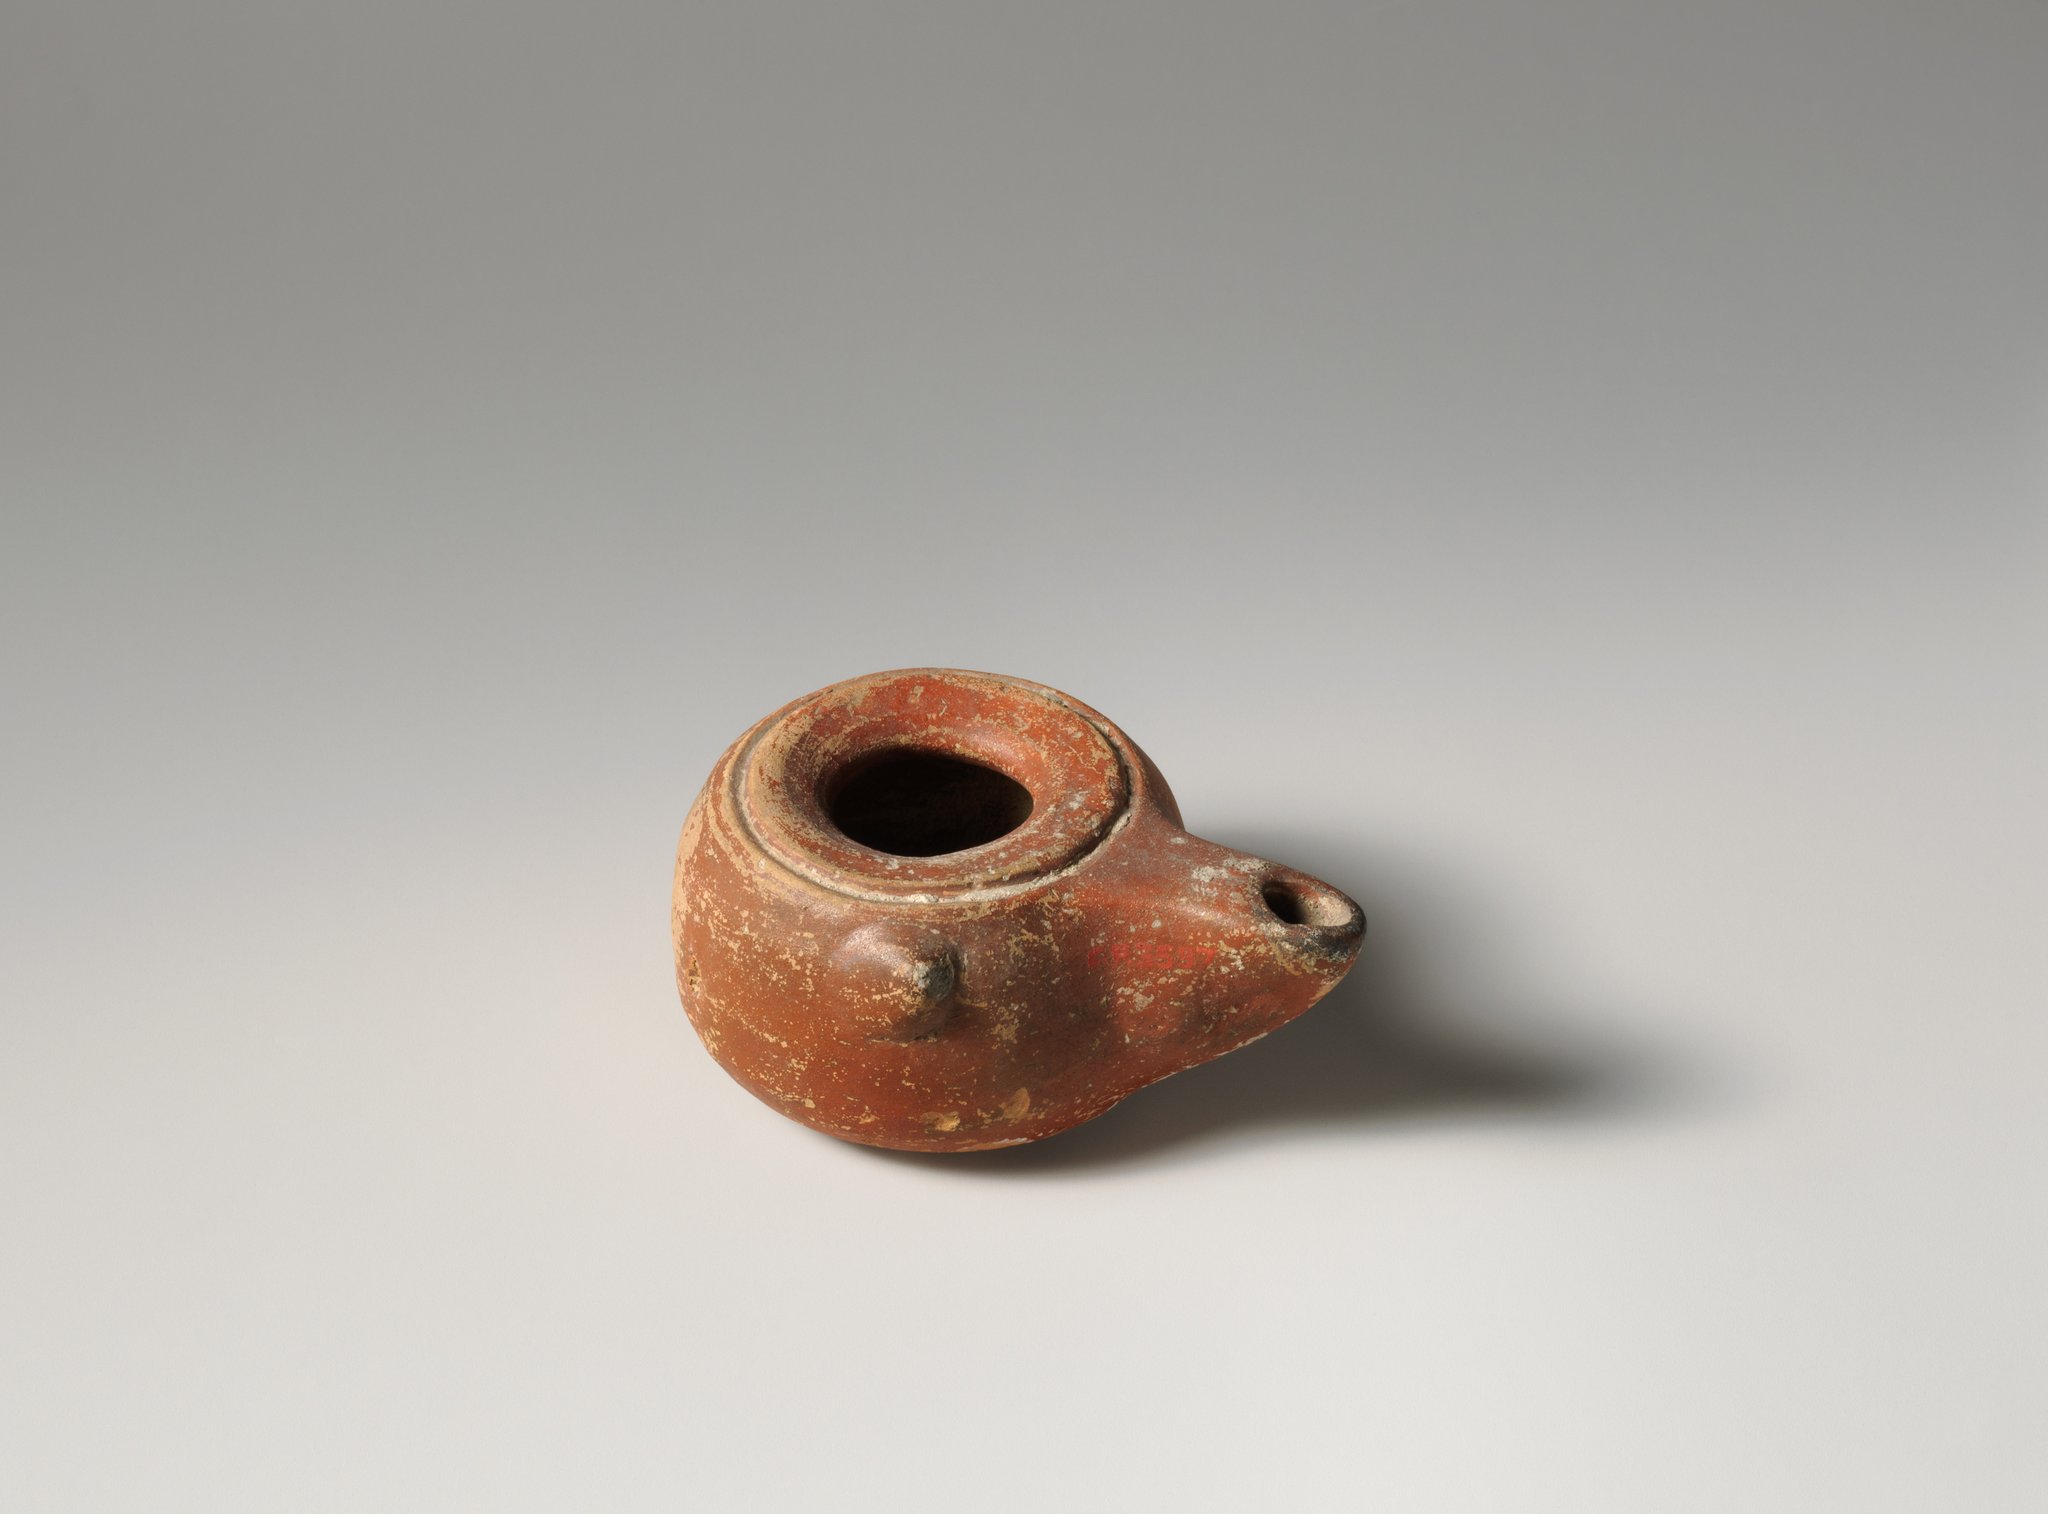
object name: lamp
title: Terracotta oil lamp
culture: greek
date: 7000 BCE-330 CE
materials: terracotta